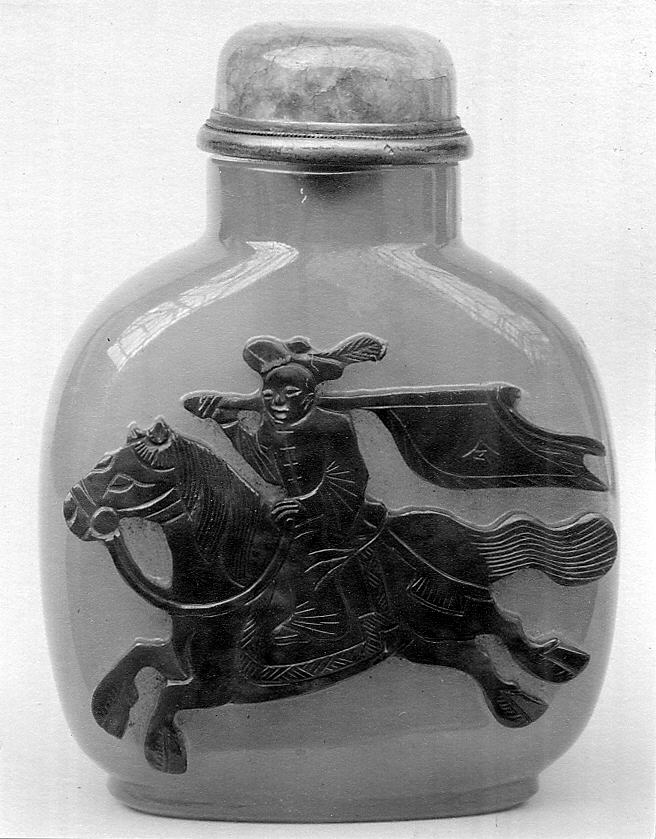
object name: snuff bottle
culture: chinese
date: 1736-1795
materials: stone, gemstone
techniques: cutting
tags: horses,flags